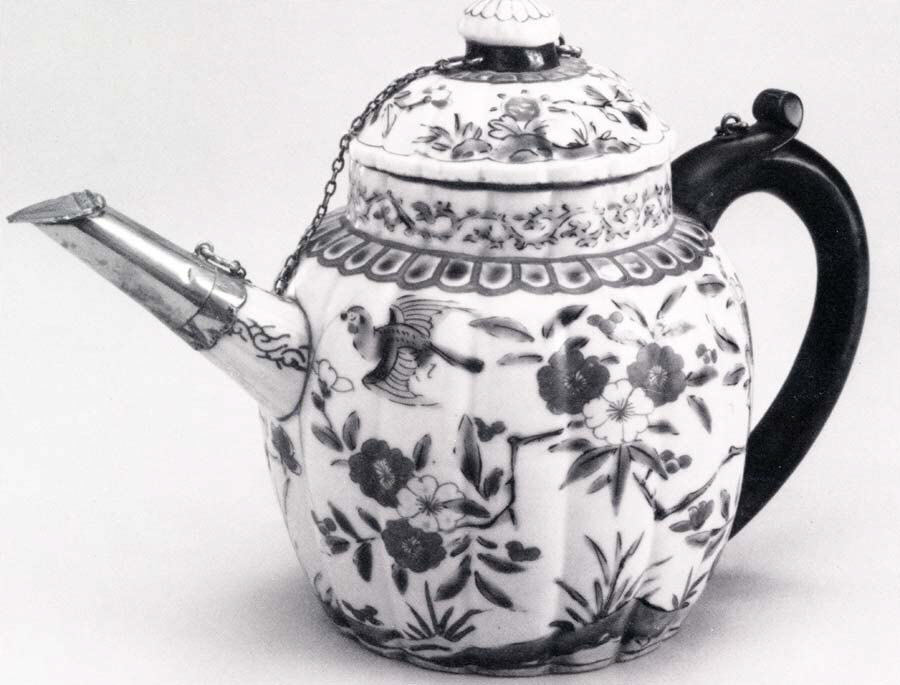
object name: teapot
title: Lobed Teapot with Floral Design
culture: japanese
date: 1667-1700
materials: enamel, porcelain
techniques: overglaze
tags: birds